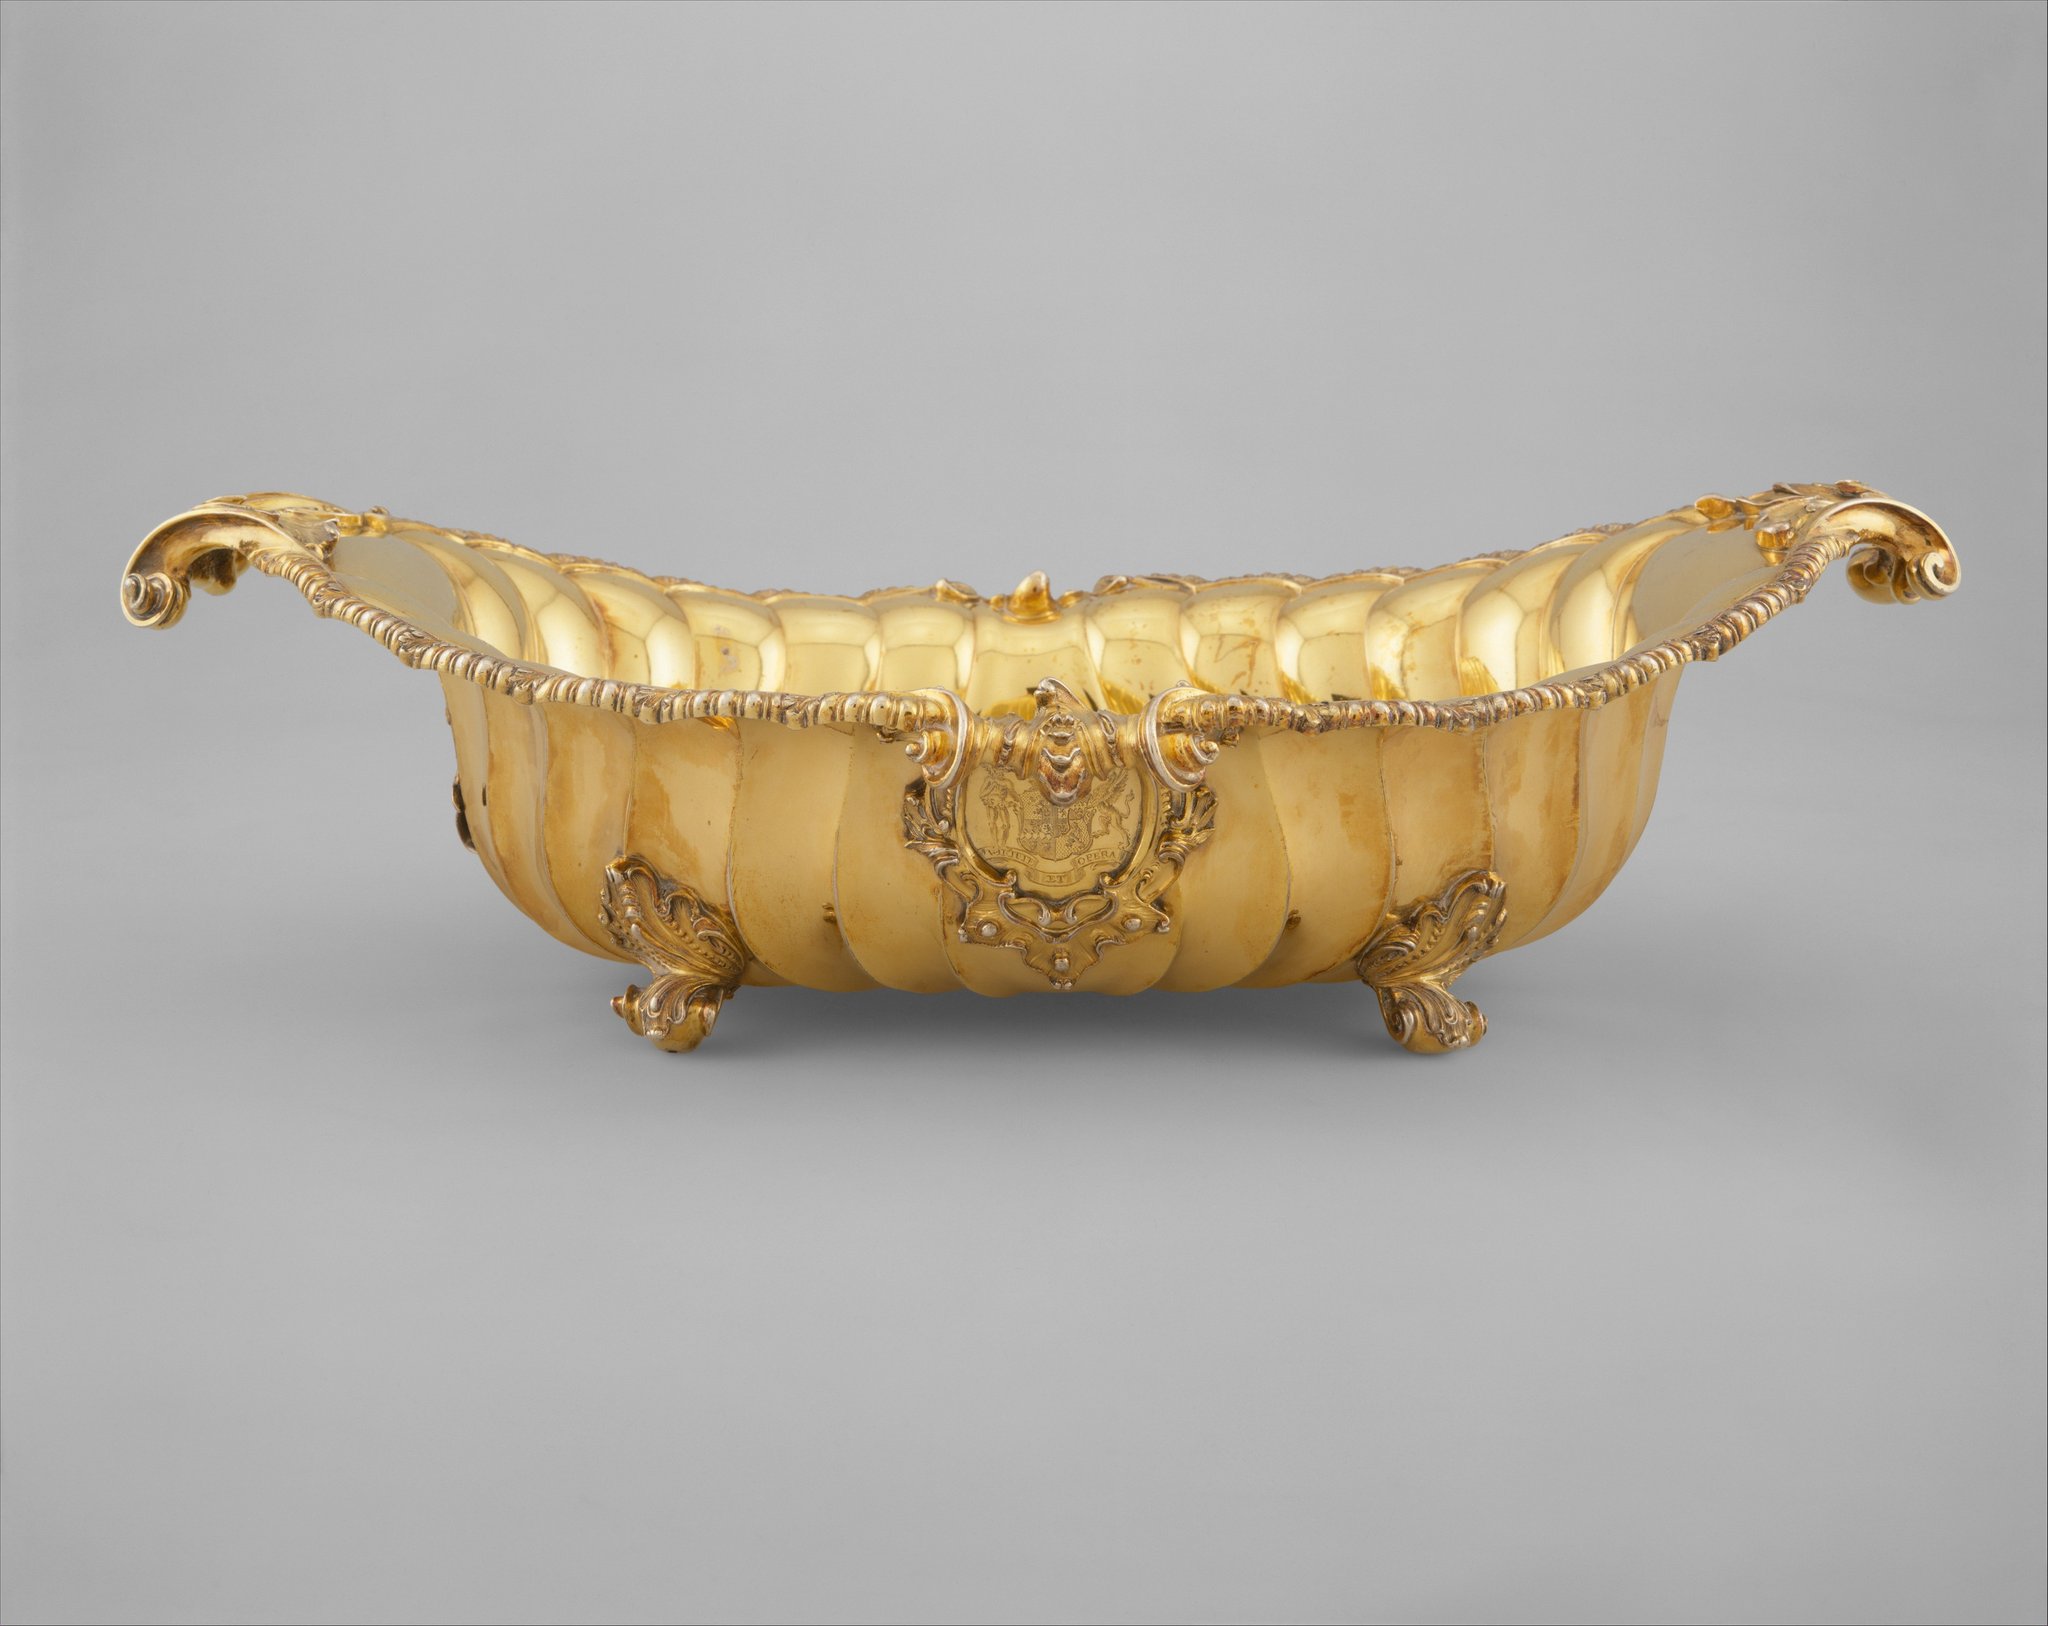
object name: fruit dish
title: Fruit dish (one of a pair)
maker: thomas heming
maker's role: maker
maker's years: 1745-1773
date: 1766-1767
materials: silver gilt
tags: coat of arms